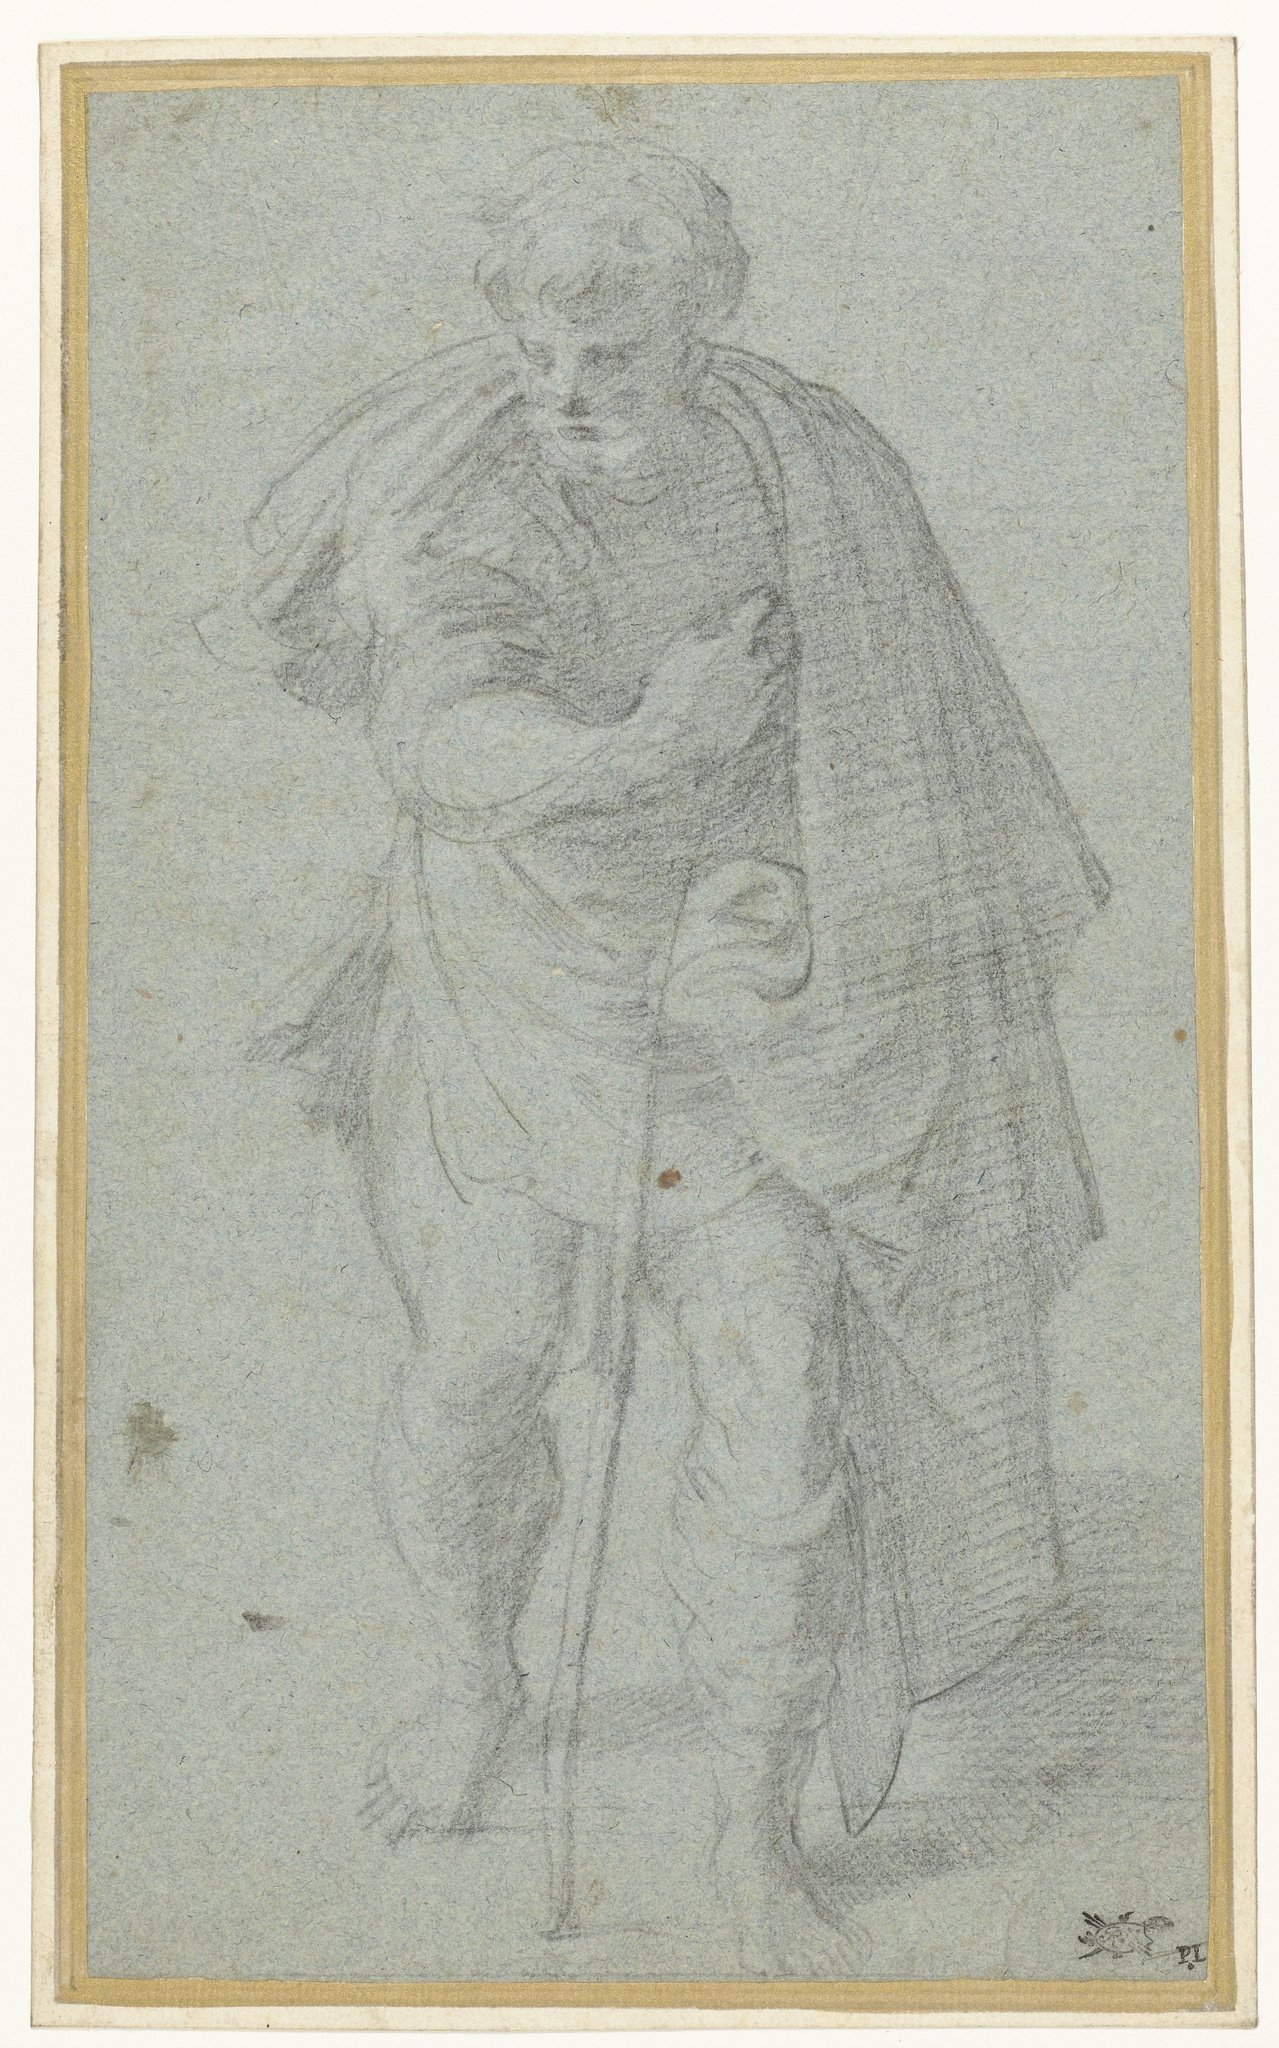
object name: drawing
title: Naar voren lopende man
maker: parmigianino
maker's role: draughtsman, painter, print maker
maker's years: 1503-1540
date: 1529-1530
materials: chalk, paper